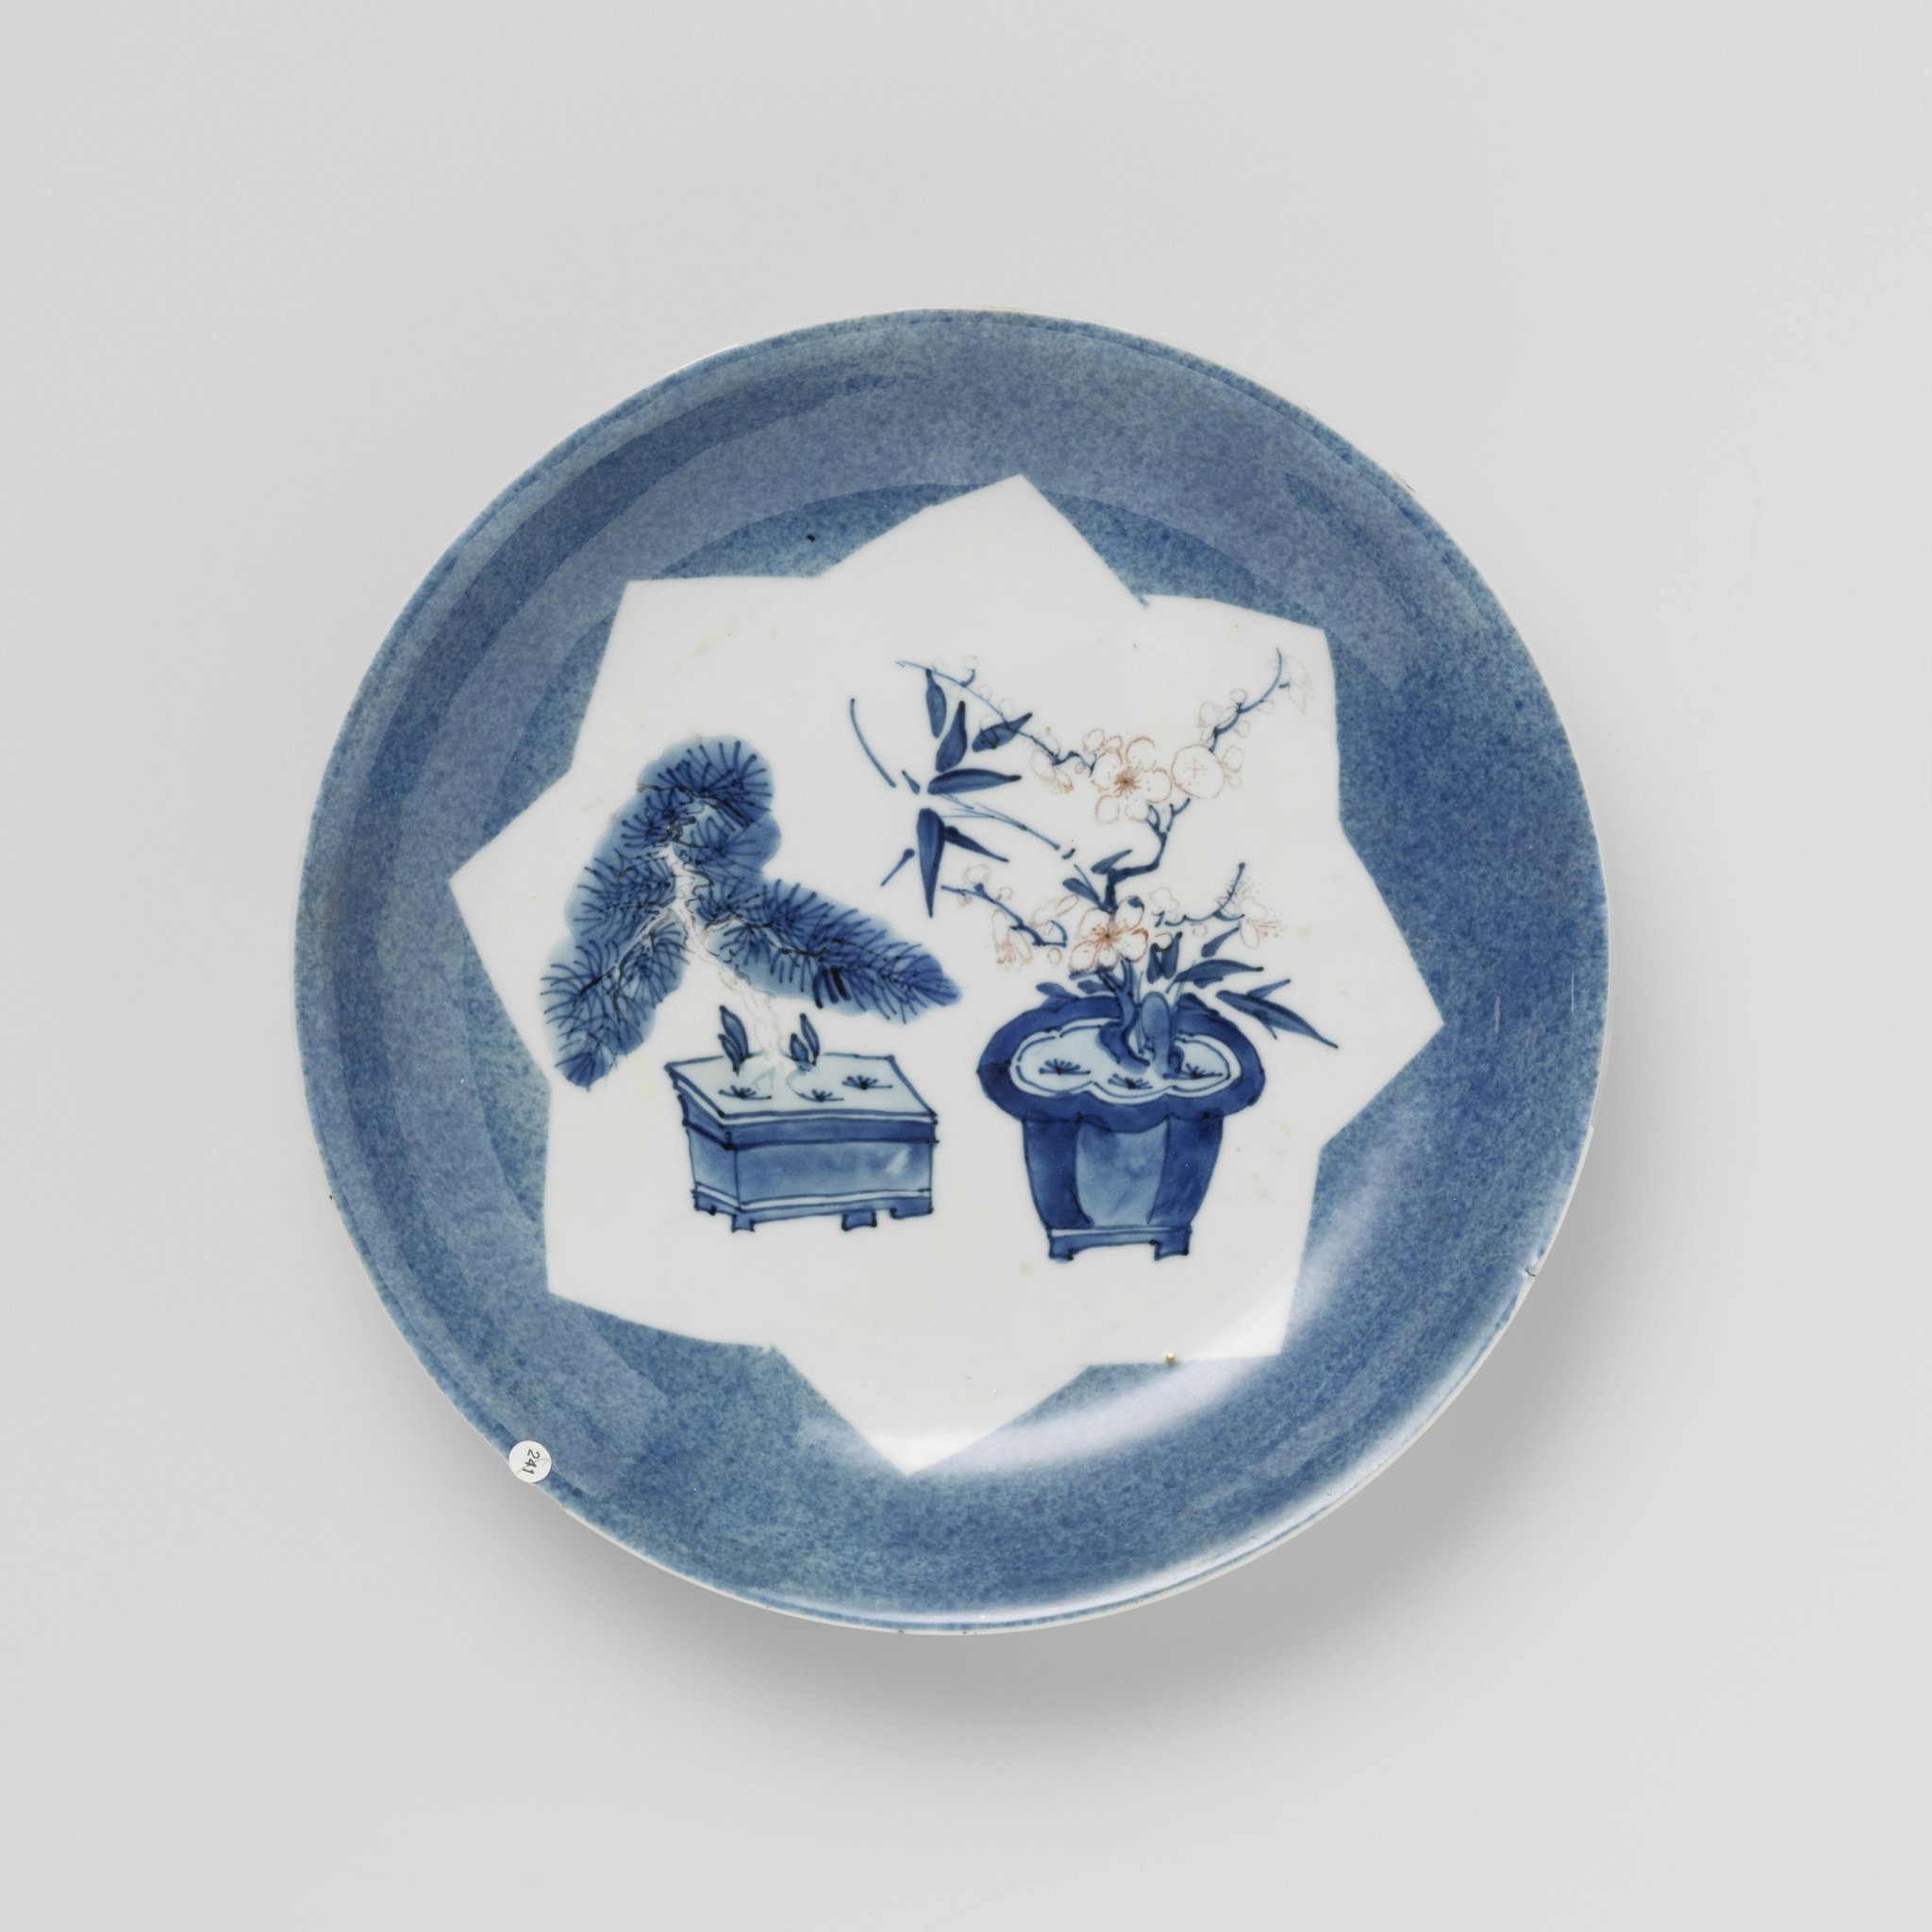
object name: dish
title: Saucer-dish with powder blue and pots with pine, bamboo and prunus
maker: Anonymous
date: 1700-1724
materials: cobalt, glaze, paint, porcelain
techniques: firing, turning, vitrification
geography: china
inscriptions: mark: ‘大 明 成 化 年 製’